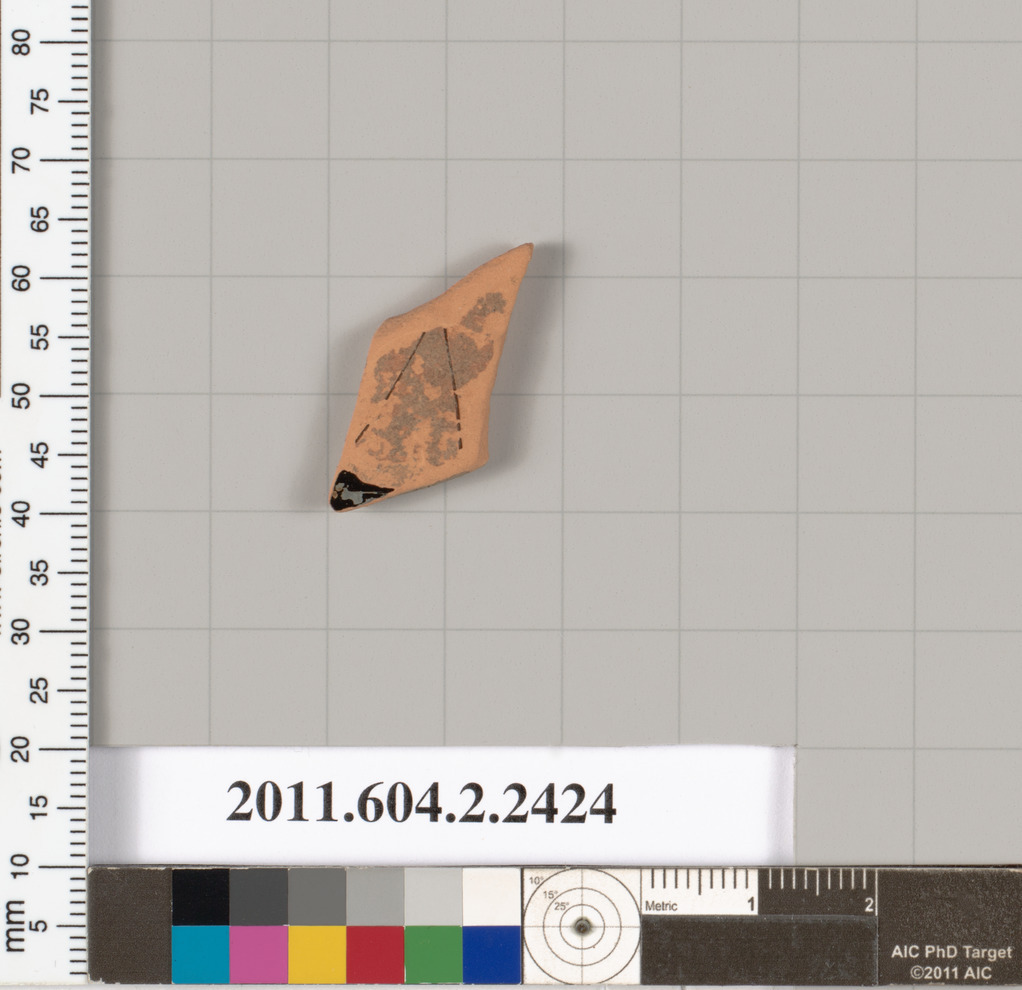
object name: undetermined closed shape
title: Terracotta fragment of a closed shape?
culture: greek, attic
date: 490-470 BCE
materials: terracotta